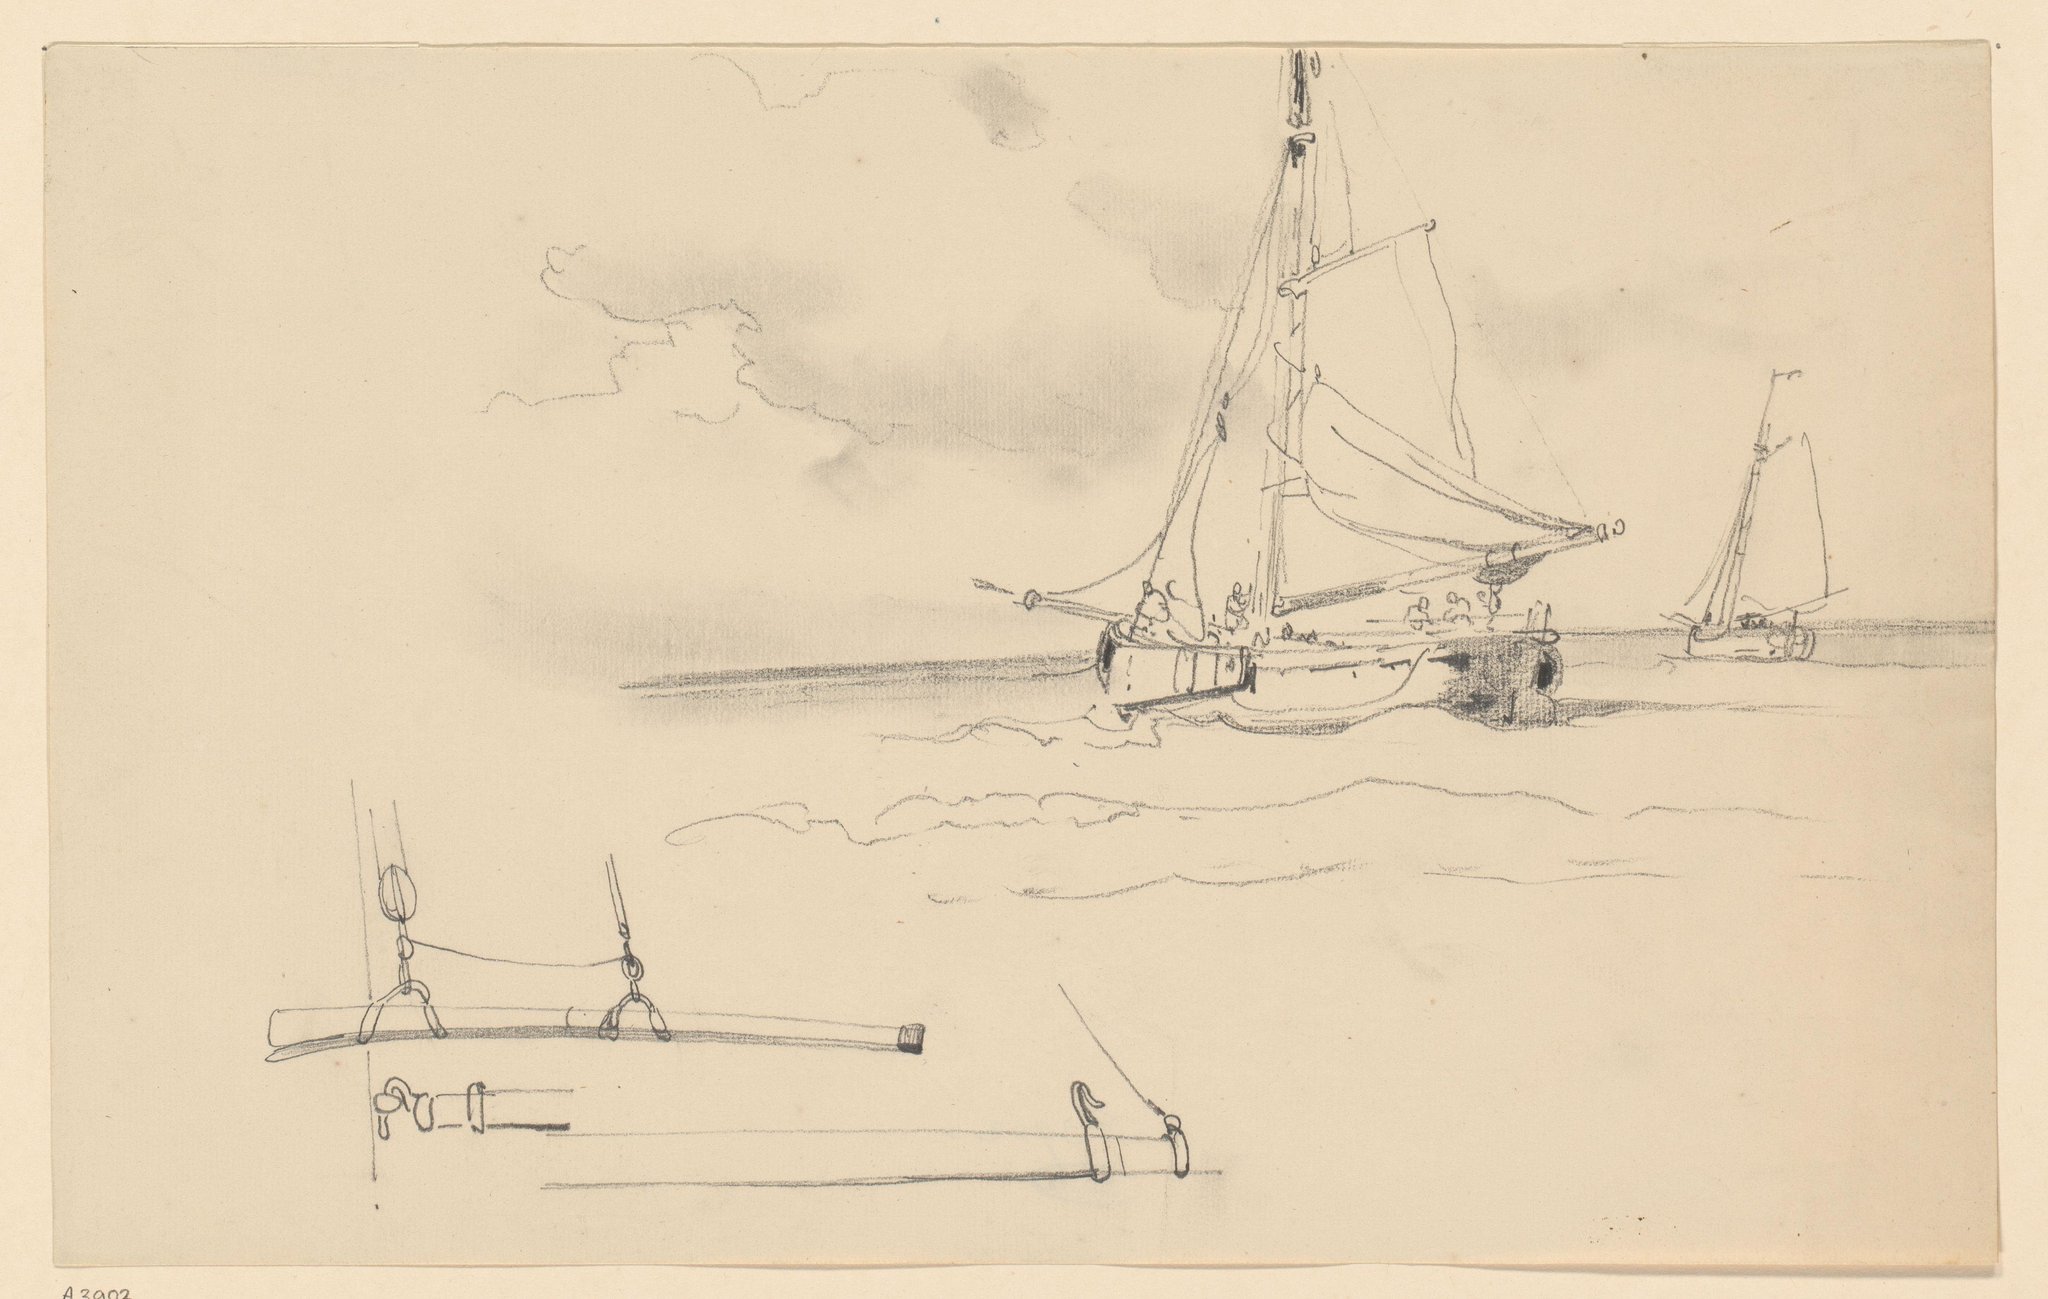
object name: drawing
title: Vissersboten en studies van een mast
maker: willem anthonie van deventer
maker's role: draughtsman, painter, print maker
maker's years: 1824-1893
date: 1834-1893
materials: chalk, paper, pencil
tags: sailing-ship, sailing-boat